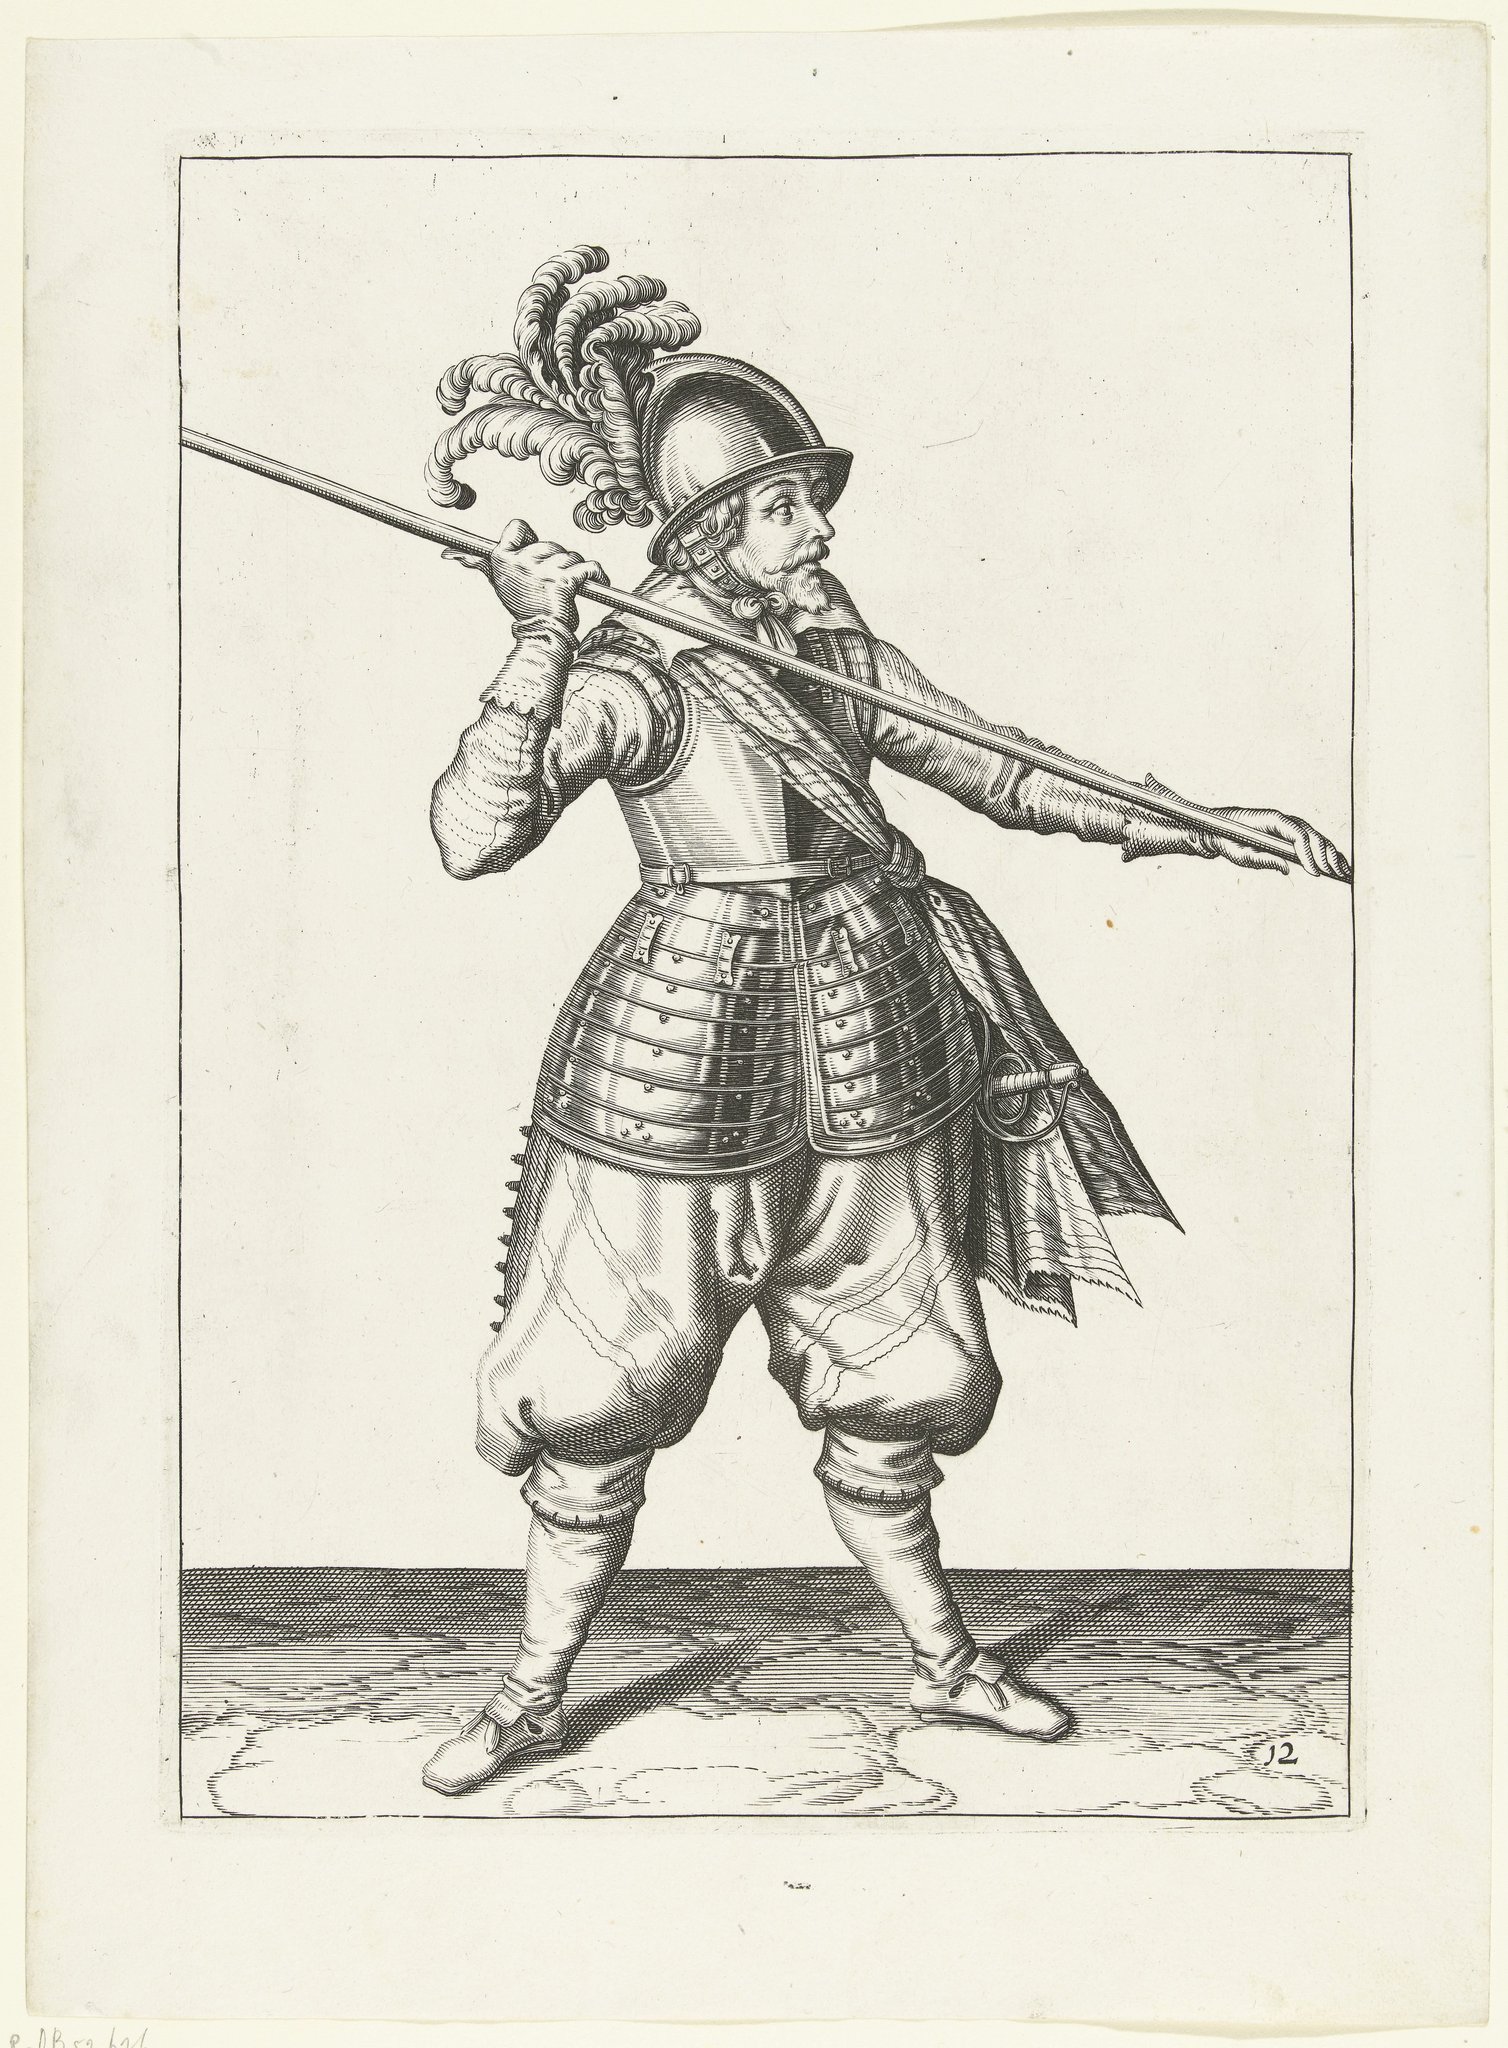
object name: print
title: Soldaat die zijn spies met beide handen ver uit elkaar boven zijn rechterschouder draagt, de punt schuin naar de grond gericht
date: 1597-1607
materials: paper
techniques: engraving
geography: netherlands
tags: manoeuvre ~ military training, warfare; military affairs (+ mercenary troops, e.g.: lansquenets), helved weapons, polearms (for striking, hacking, thrusting): lance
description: Een soldaat, ten voeten uit, die een spies (lans) boven zijn rechterschouder draagt, de punt schuin naar de grond gericht. Zijn handen ver uit elkaar om de spies. Dit is de eerste handeling voor het laten zakken van de spies om onder een overwelving door te kunnen. Deze prent is onderdeel van de reeks van 32 genummerde prenten van spiesdragers uit de Wapenhandelinghe.